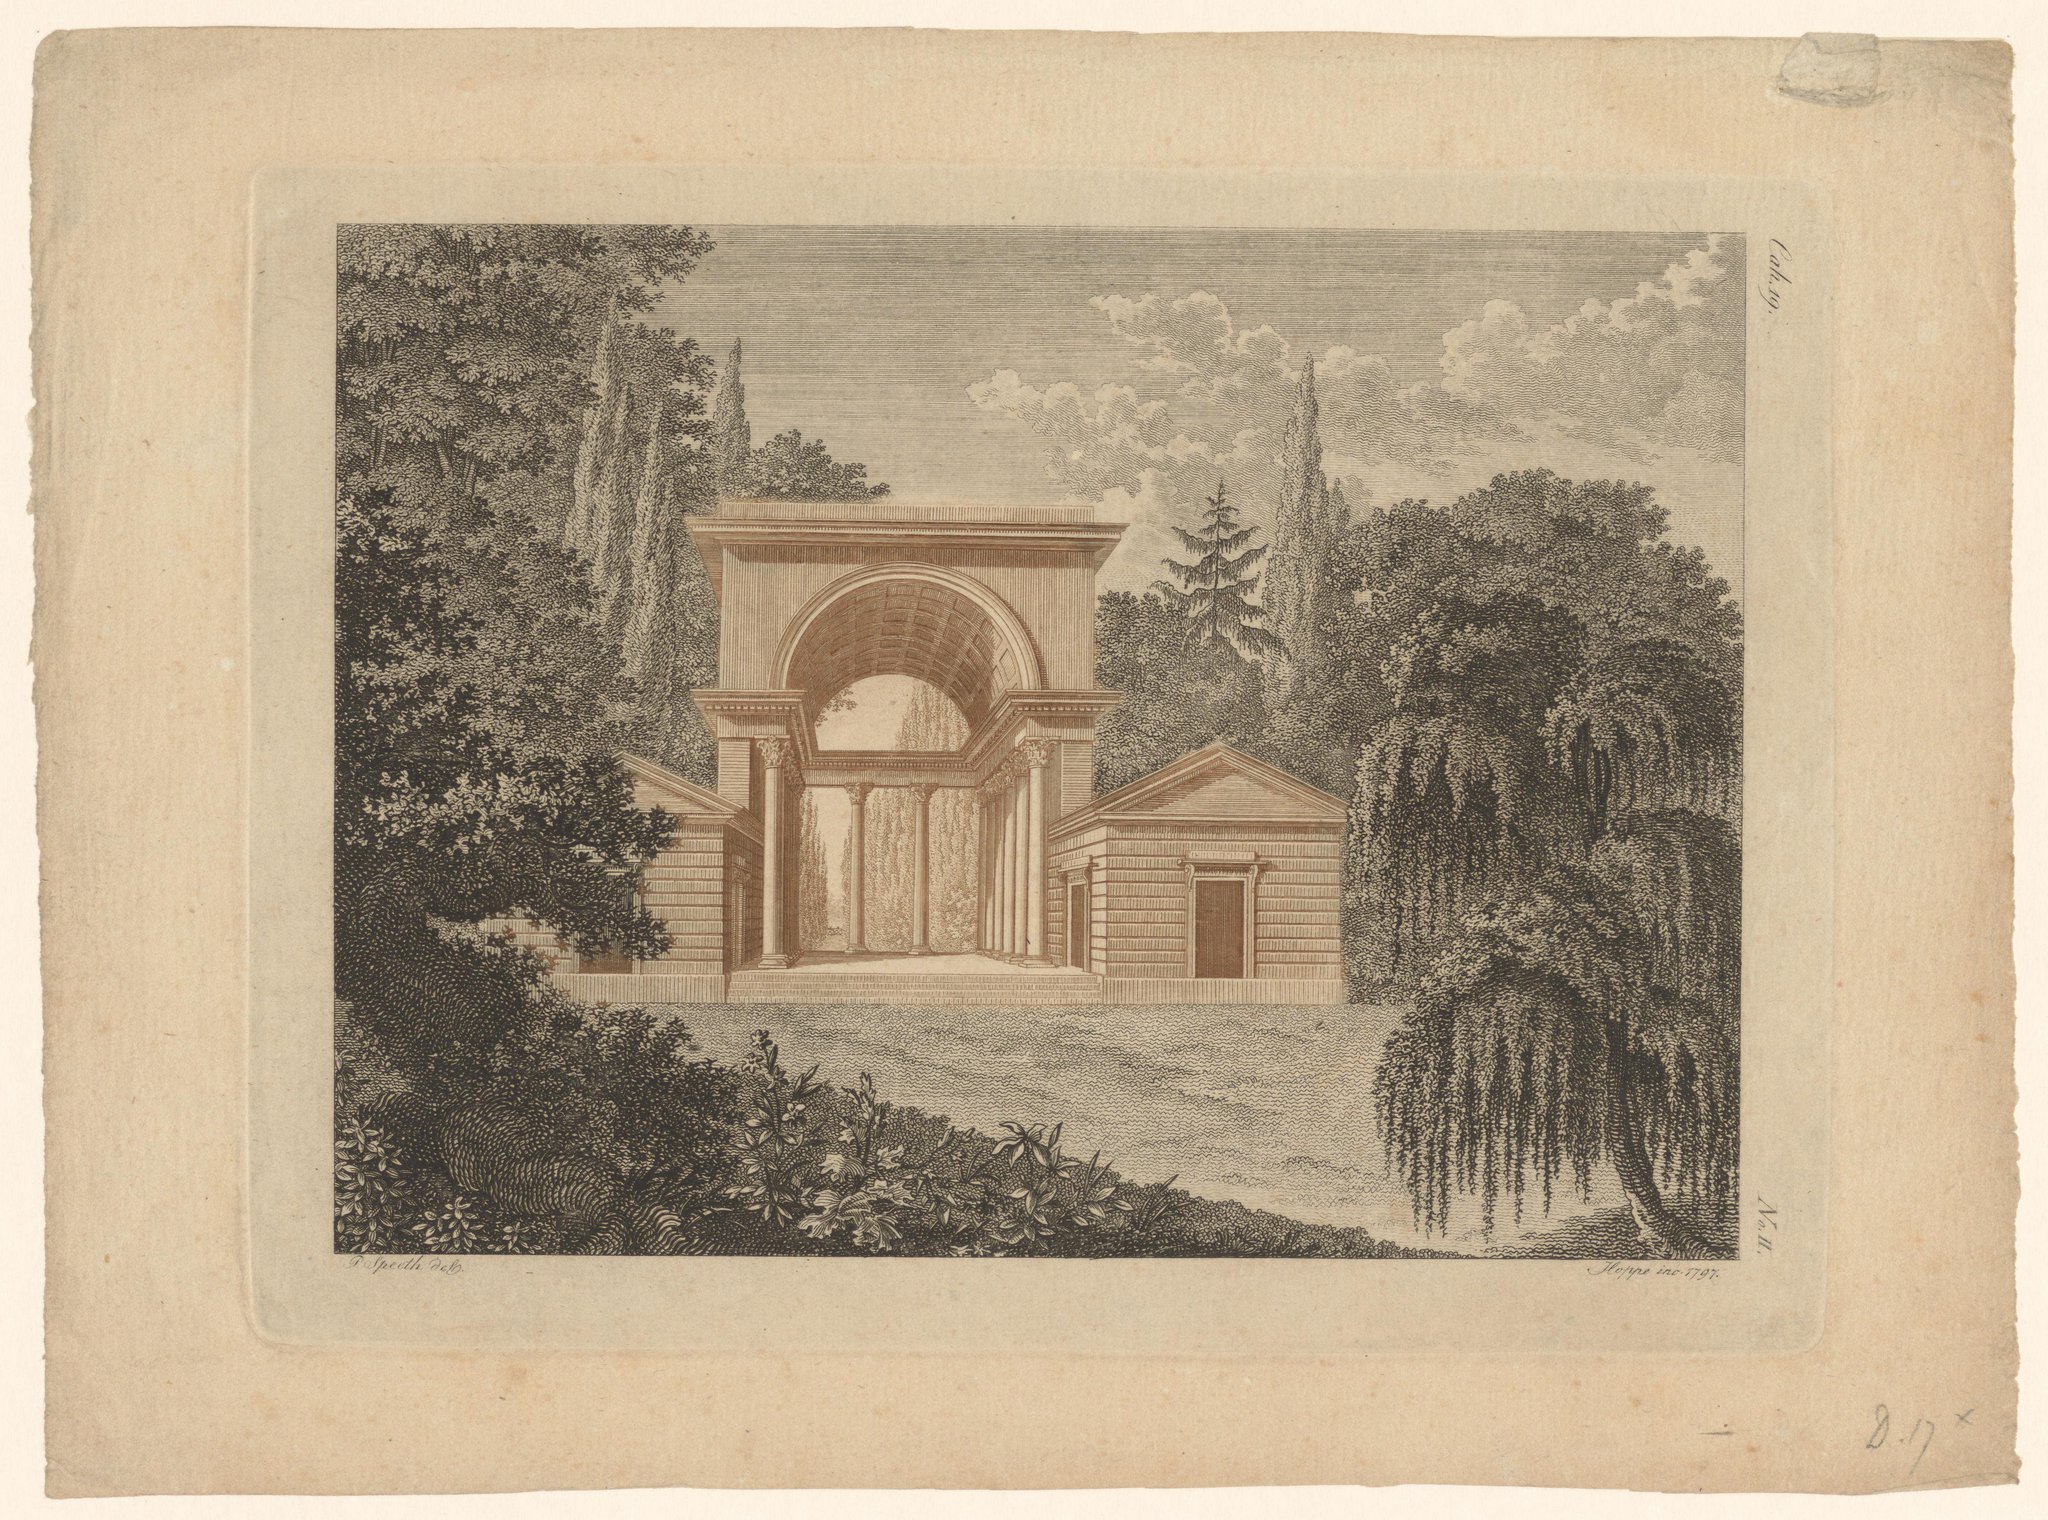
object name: print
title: Arcade in bosrijke omgeving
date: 1797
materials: paper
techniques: engraving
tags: forest, wood - hh - ideal landscapes, landscape with monument - ii - ideal landscapes, garden buildings, arcade ~ architecture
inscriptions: collector's mark: Lugt 2228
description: Dit is de tweede prent uit een serie met rechtsboven de tekst 'Cah. 19.'.